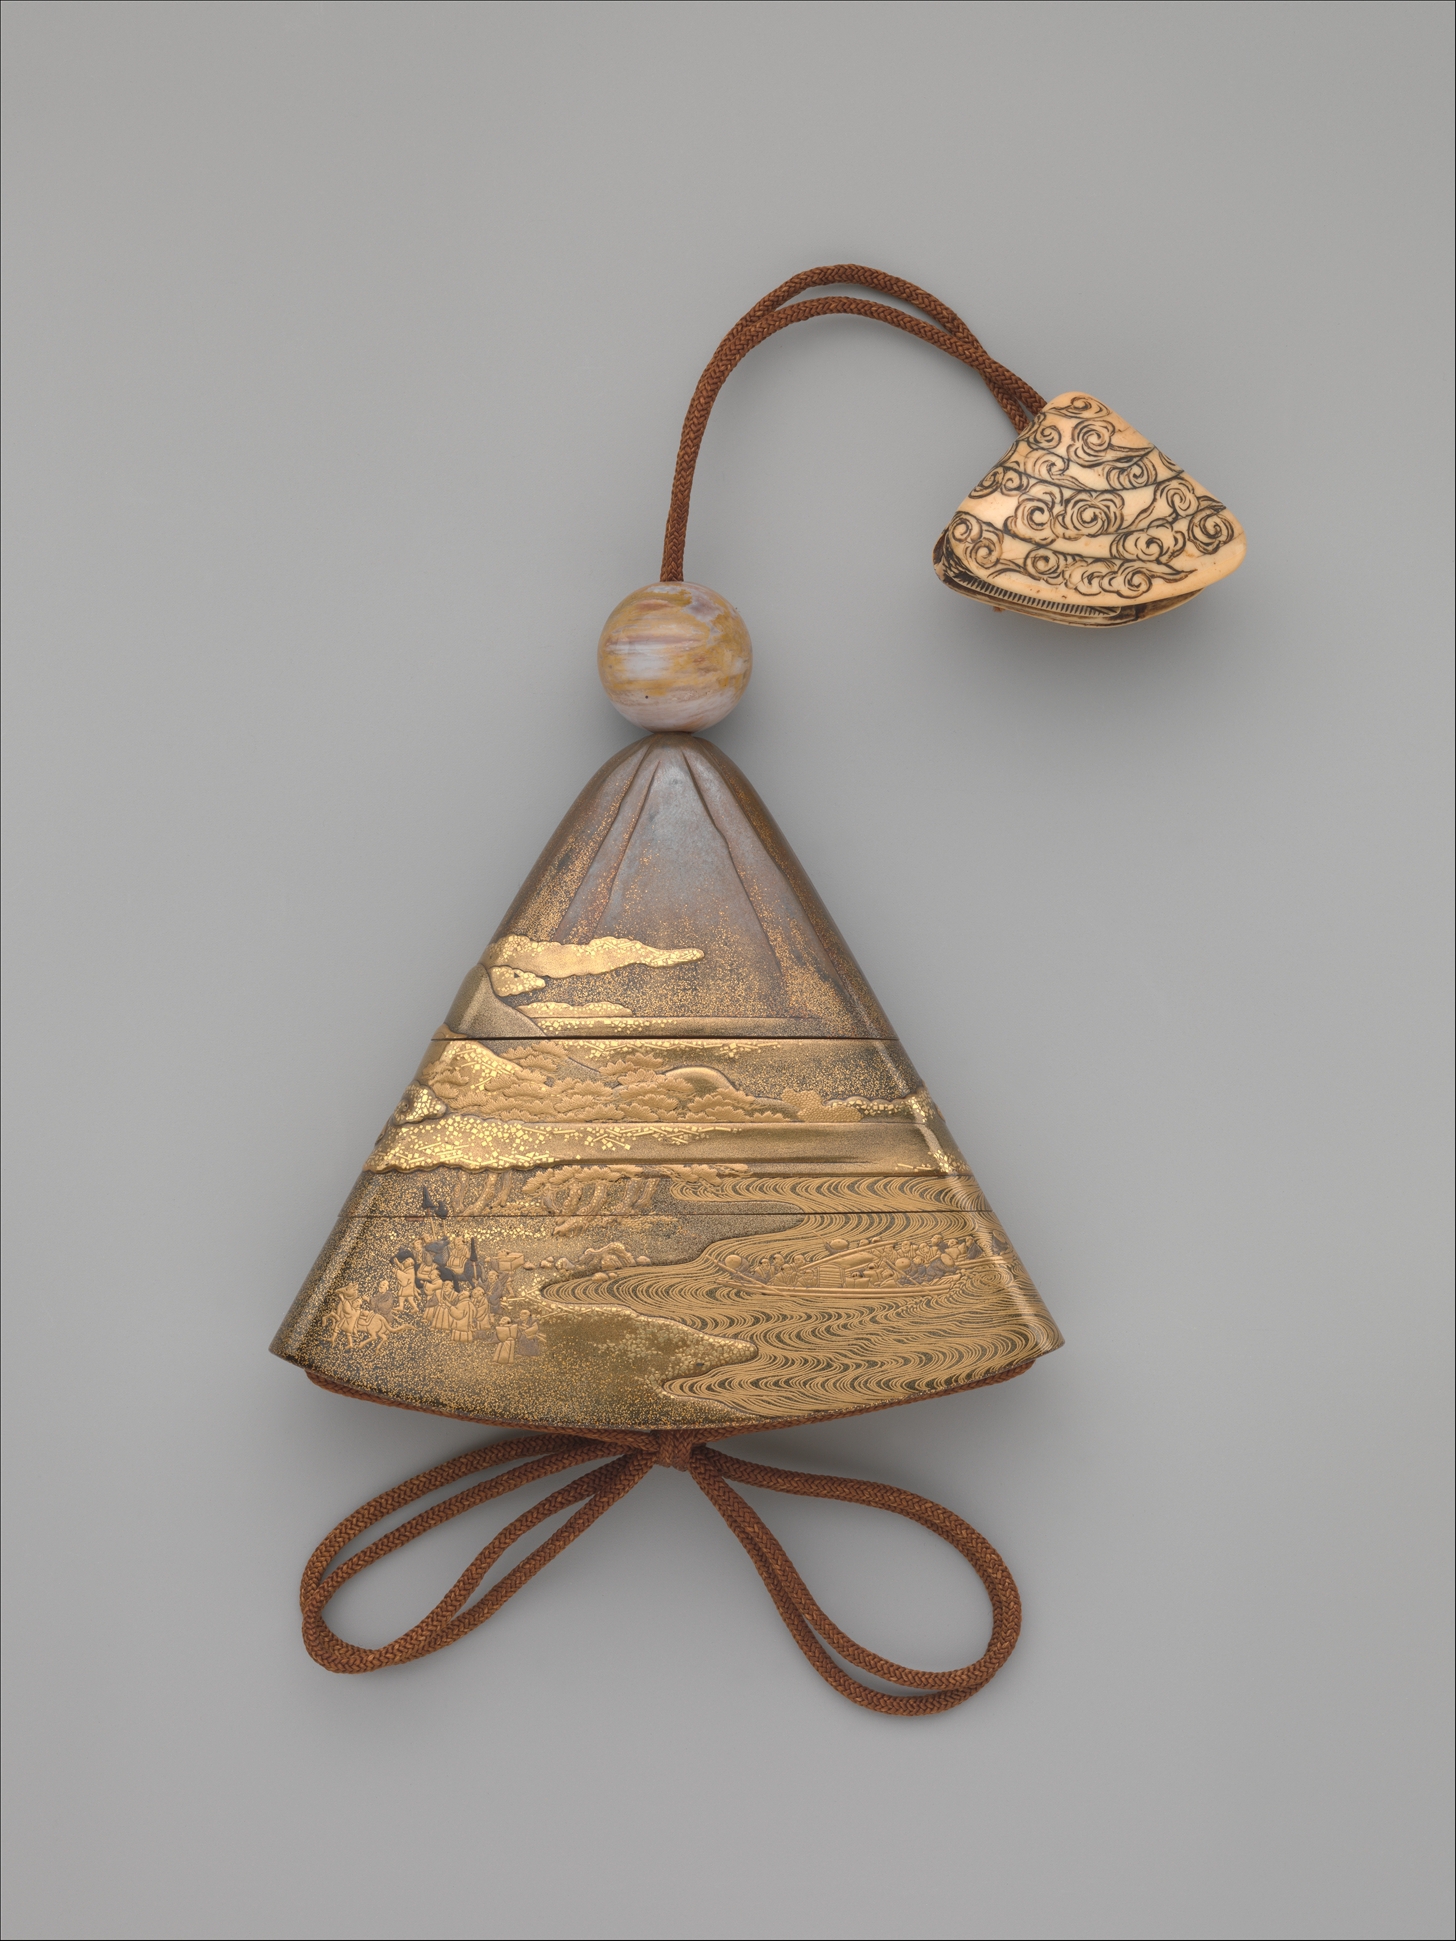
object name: inrō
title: Inrō in the Shape of Mount Fuji with a Crossing Ferry and Procession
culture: japanese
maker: kajikawa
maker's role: artist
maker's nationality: japanese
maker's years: 1652-1724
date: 1767-1833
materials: stone, gold, gold foil, ivory, lacquer, silver, wood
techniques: cutting, hiramakie, lacquer, maki-e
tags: mountains,boats